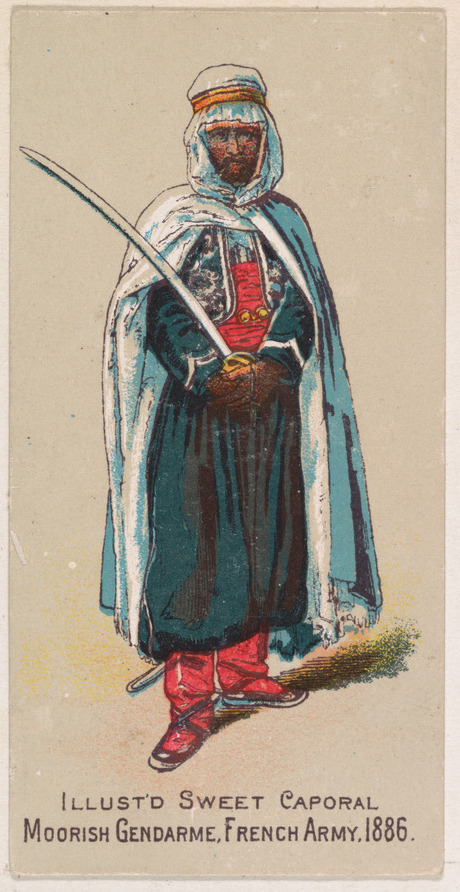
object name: print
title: Moorish Gendarme, French Army, 1886, from the Military Series (N224) issued by Kinney Tobacco Company to promote Sweet Caporal Cigarettes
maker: kinney brothers tobacco company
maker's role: publisher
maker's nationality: american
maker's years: 1869-2011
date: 1888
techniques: color lithograph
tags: military,swords,men